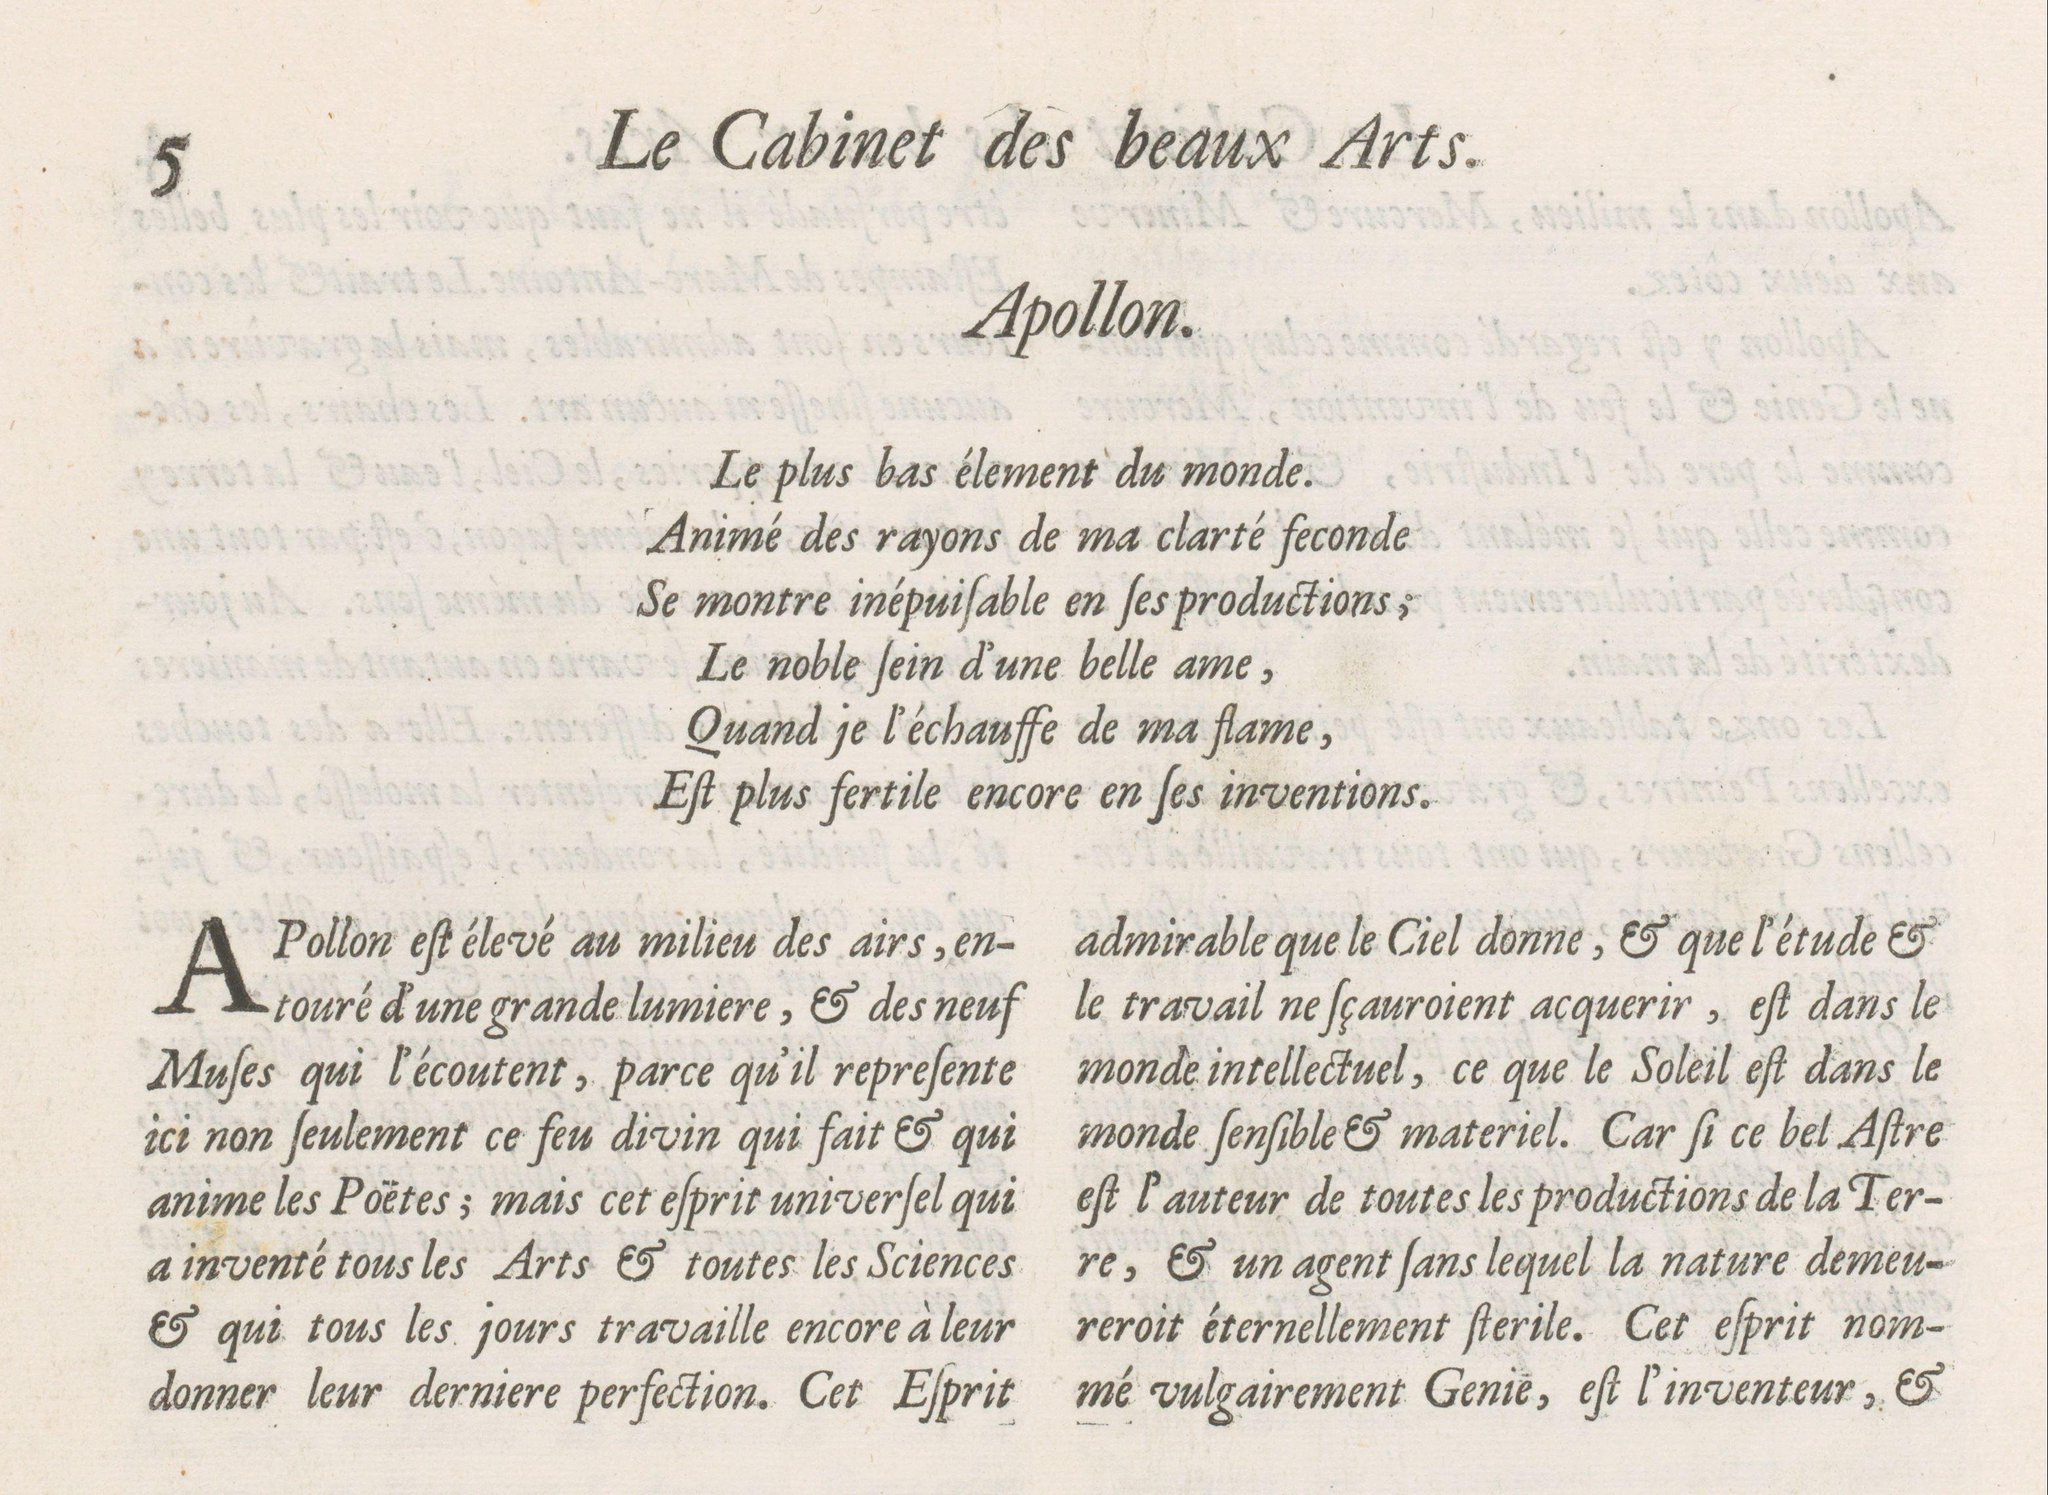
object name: album leaf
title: Apollo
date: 1695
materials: paper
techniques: letterpress printing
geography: paris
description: Verklaring van de prent met voorstelling van Apollo (ontbreekt in album) in het Frans. Pagina 5. Tekstblad maakt deel uit van een album.